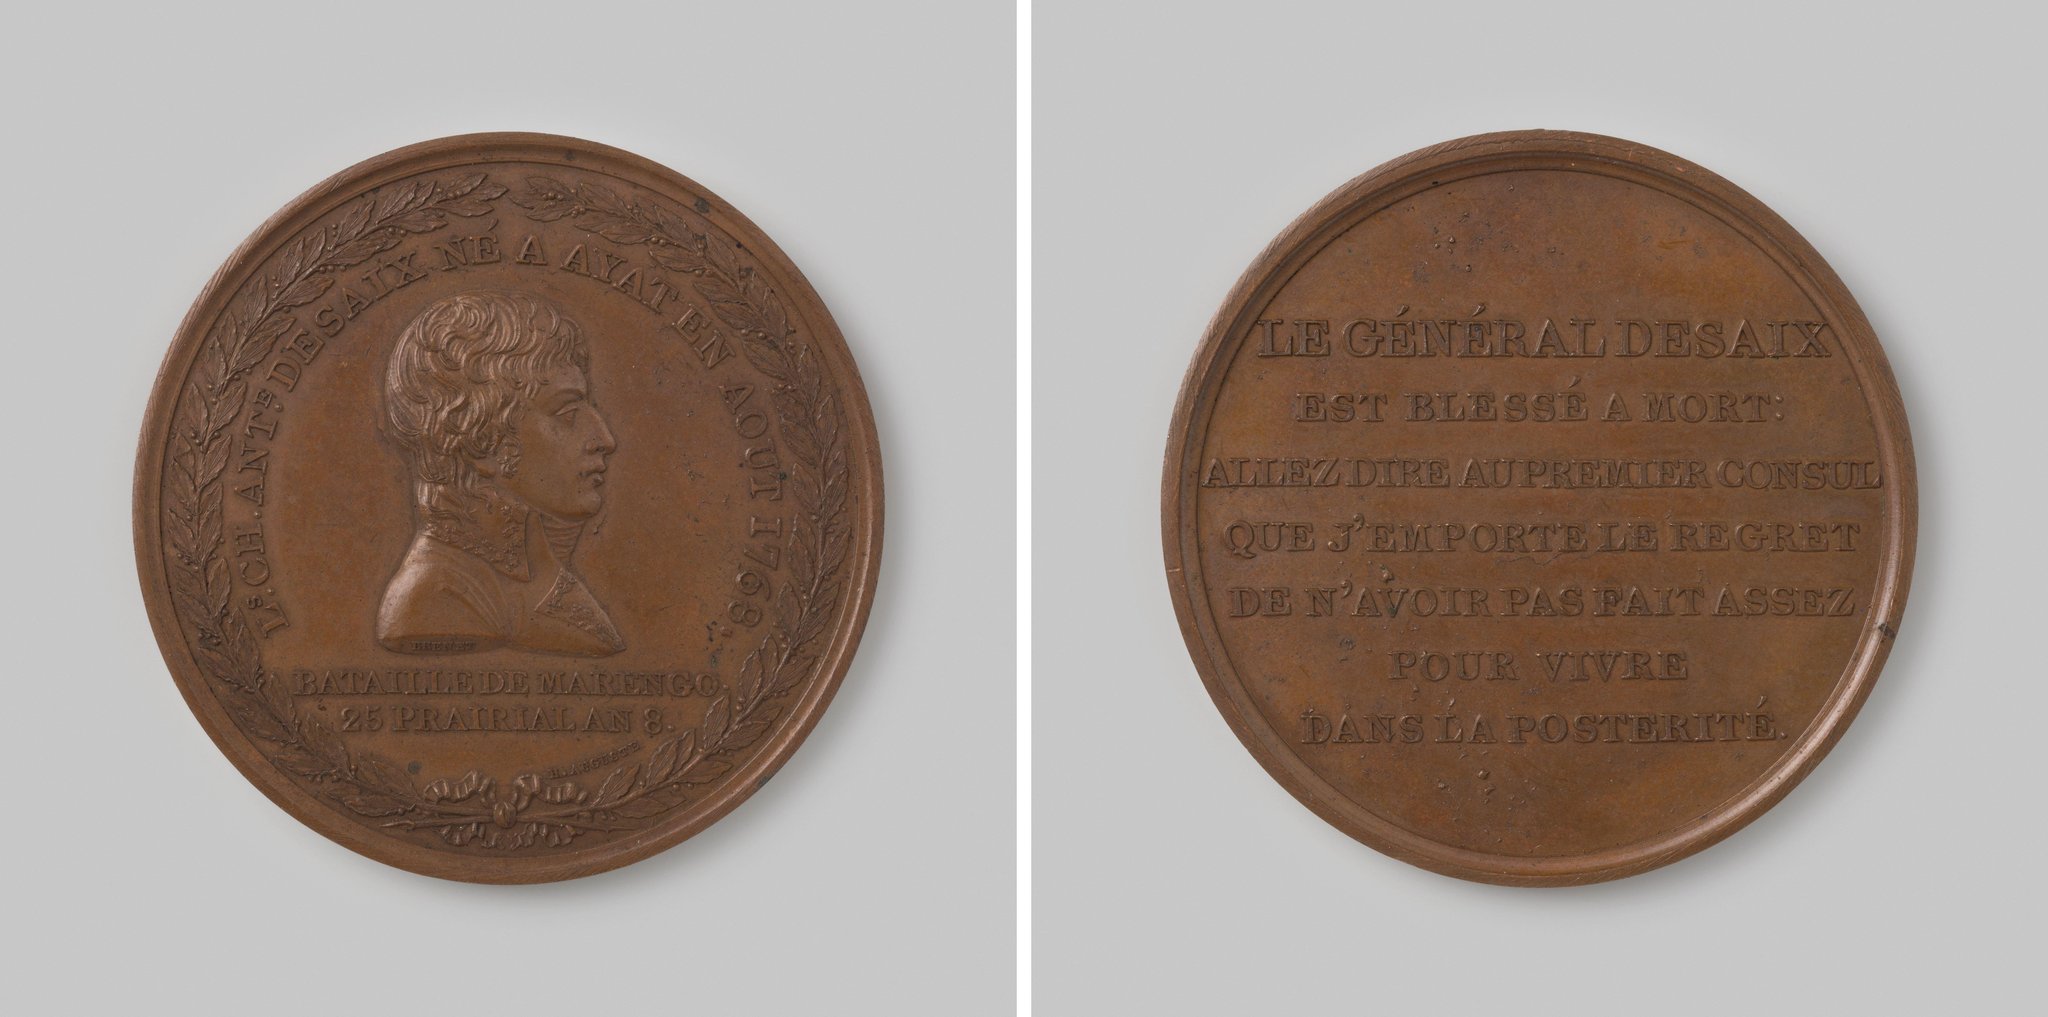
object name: history medal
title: Overlijden van generaal Desaix in de veldslag bij Marengo 1800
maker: h. auguste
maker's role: die cutter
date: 1800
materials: copper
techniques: striking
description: Bronzen penning, op de voorzijde het borstbeeld van Desaix met omschrift en afsnedetekst tussen samengestrikte lauwertakken, op de keerzijde zeven regels tekst.